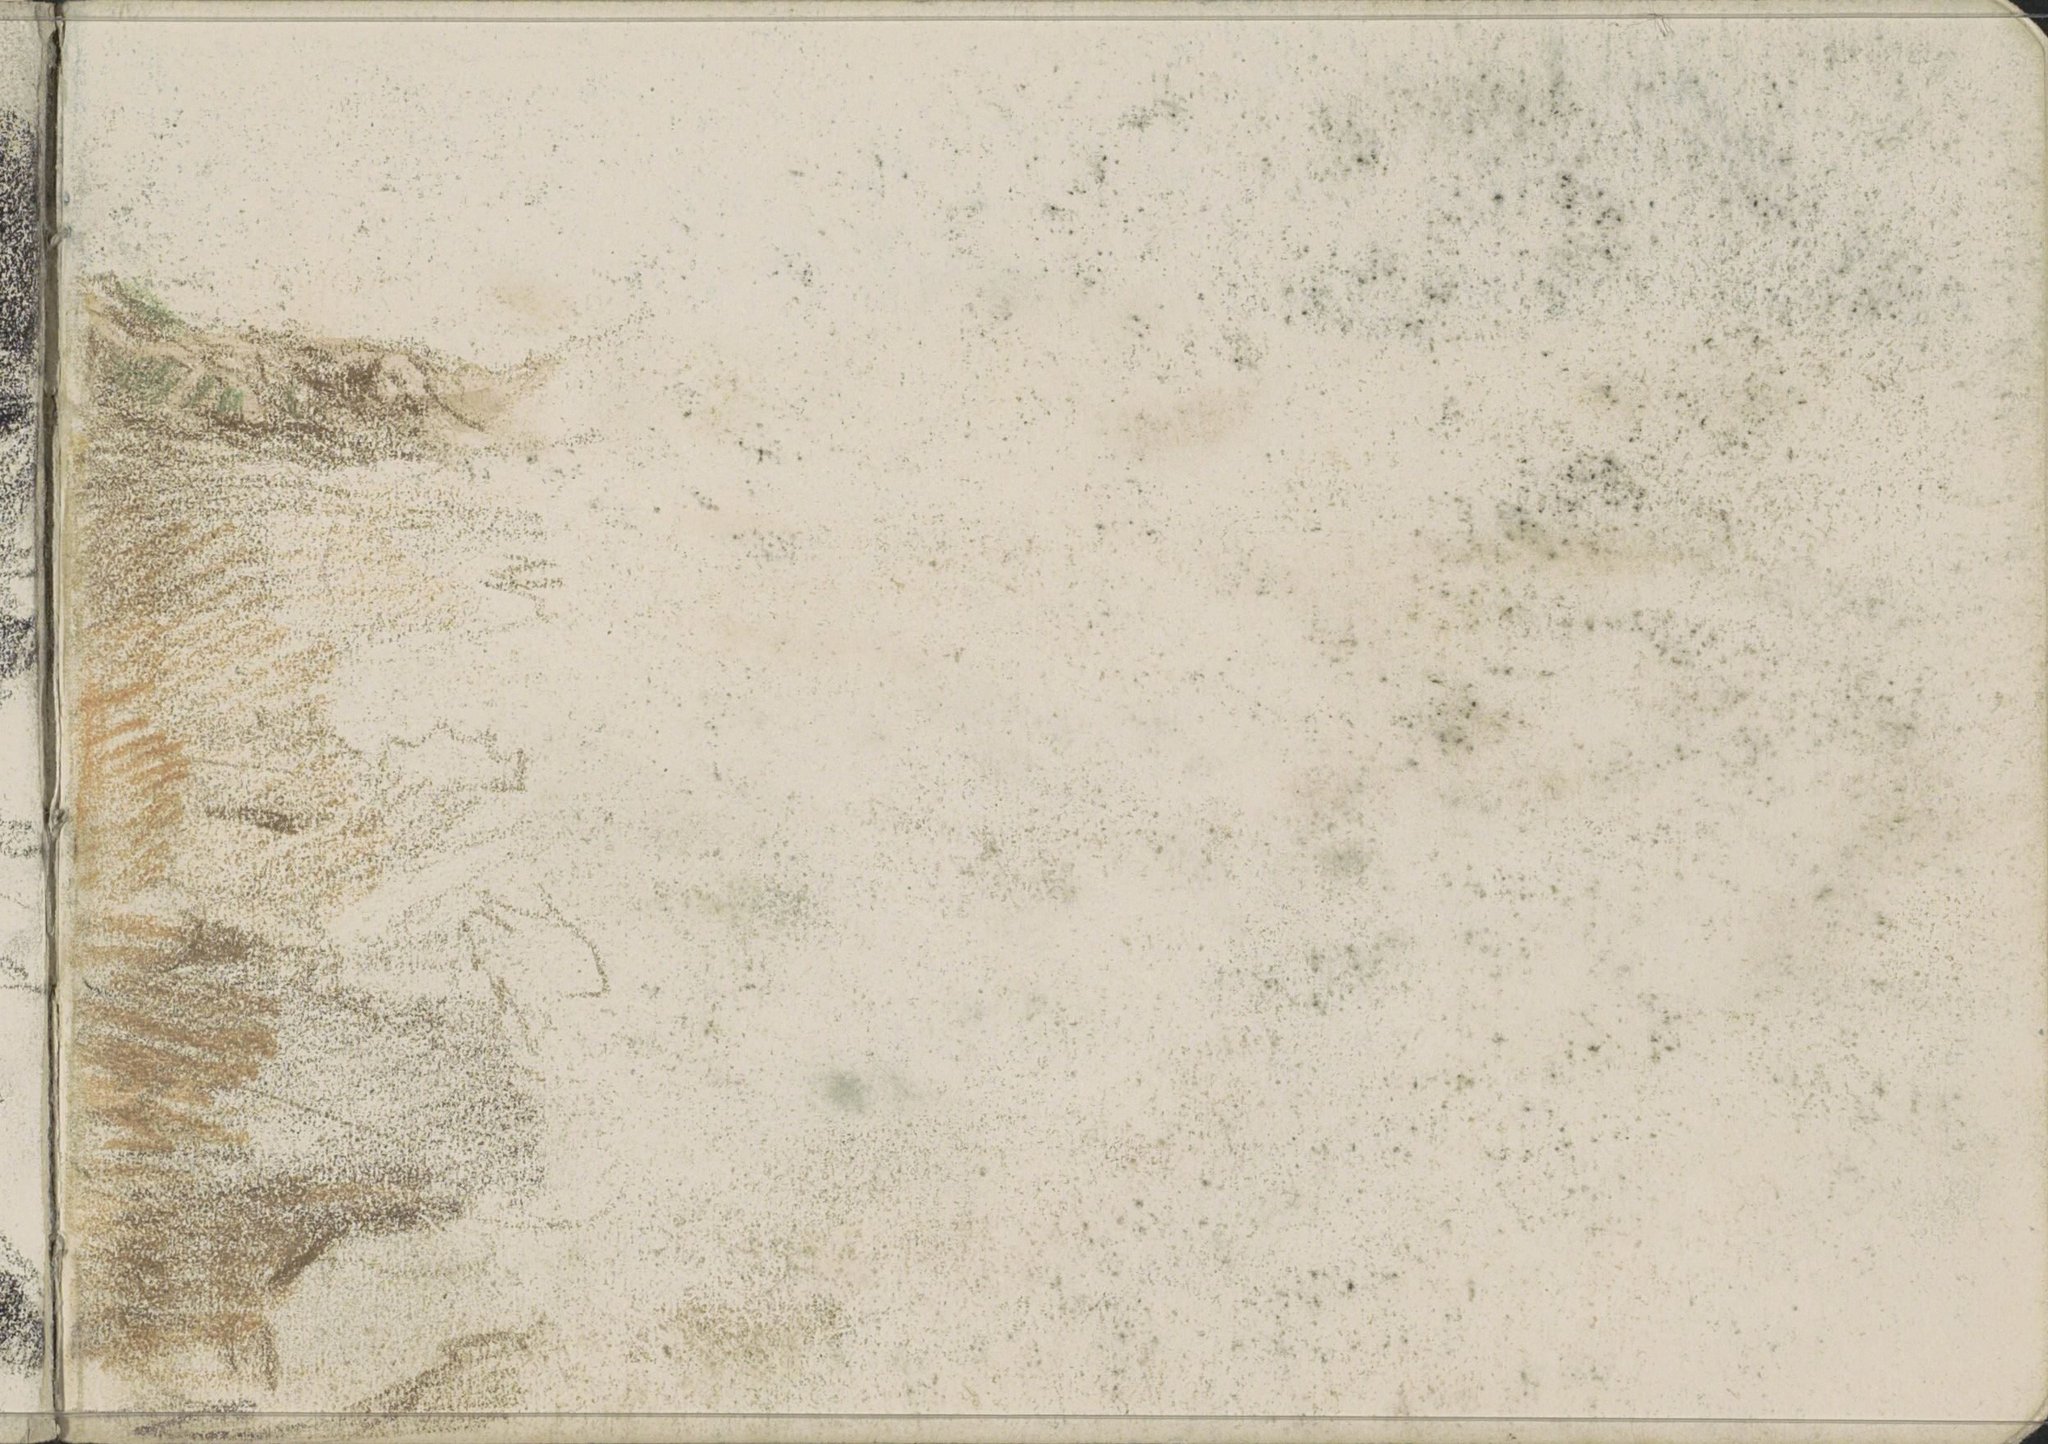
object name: sketchbook leaf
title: Duinlandschap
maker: johan antonie de jonge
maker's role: draughtsman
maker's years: 1864-1927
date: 1881-1927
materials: chalk, paper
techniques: stumping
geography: south holland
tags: dunes (sea not visible); in the dunes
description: Duinlandschap. Blad 21 recto uit een schetsboek met 28 bladen.